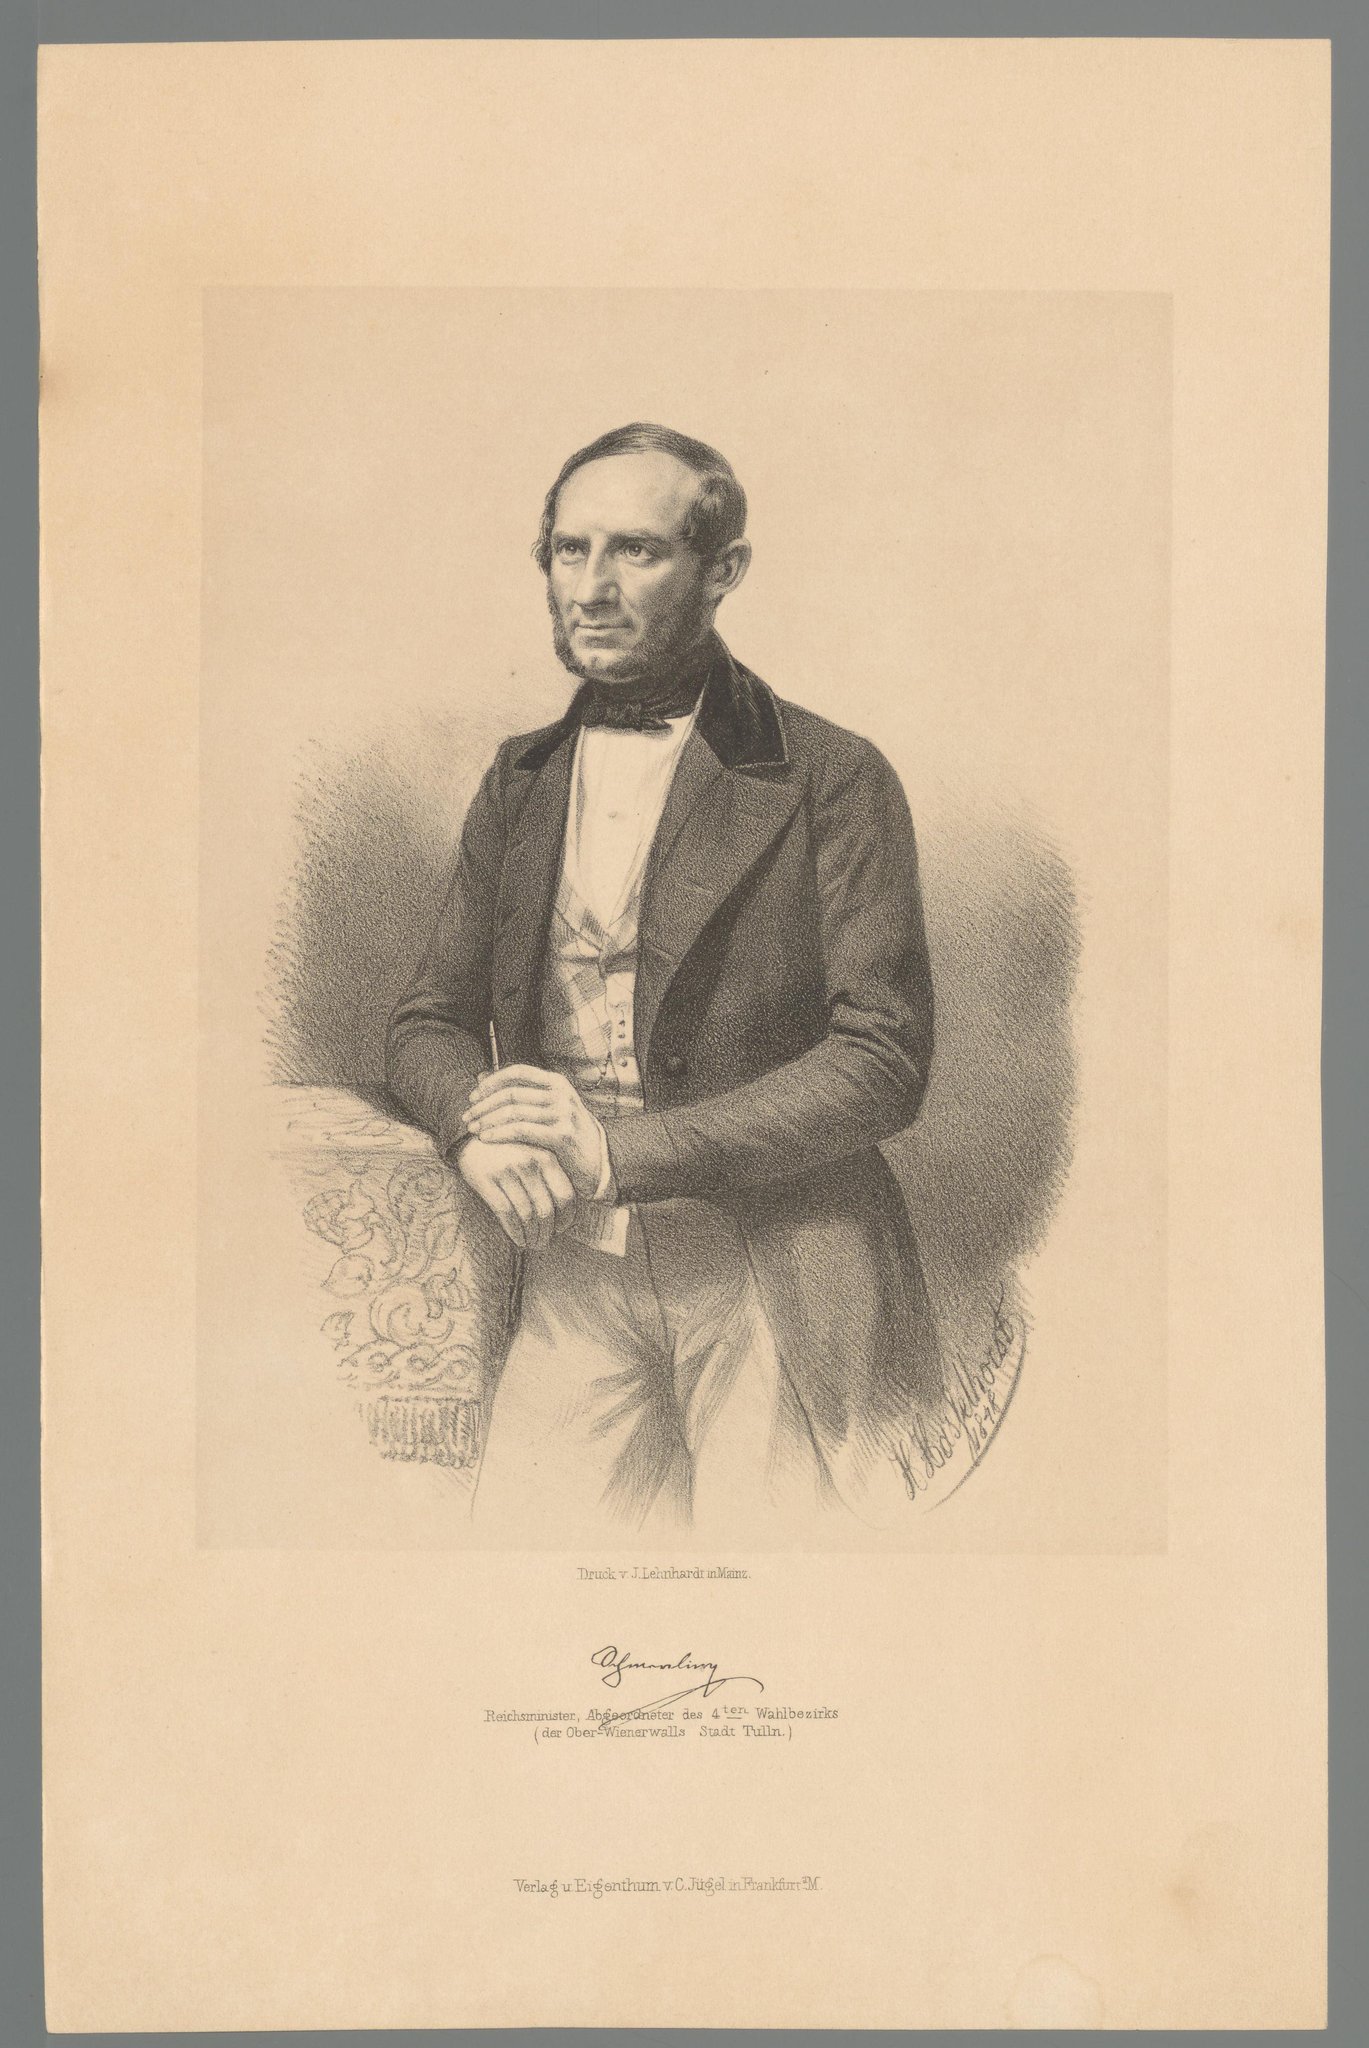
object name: print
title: Portret van Anton von Schmerling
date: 1848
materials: paper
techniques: lithograph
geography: frankfurt am main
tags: vienna, minister ~ government, historical persons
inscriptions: collector's mark: Lugt 2228